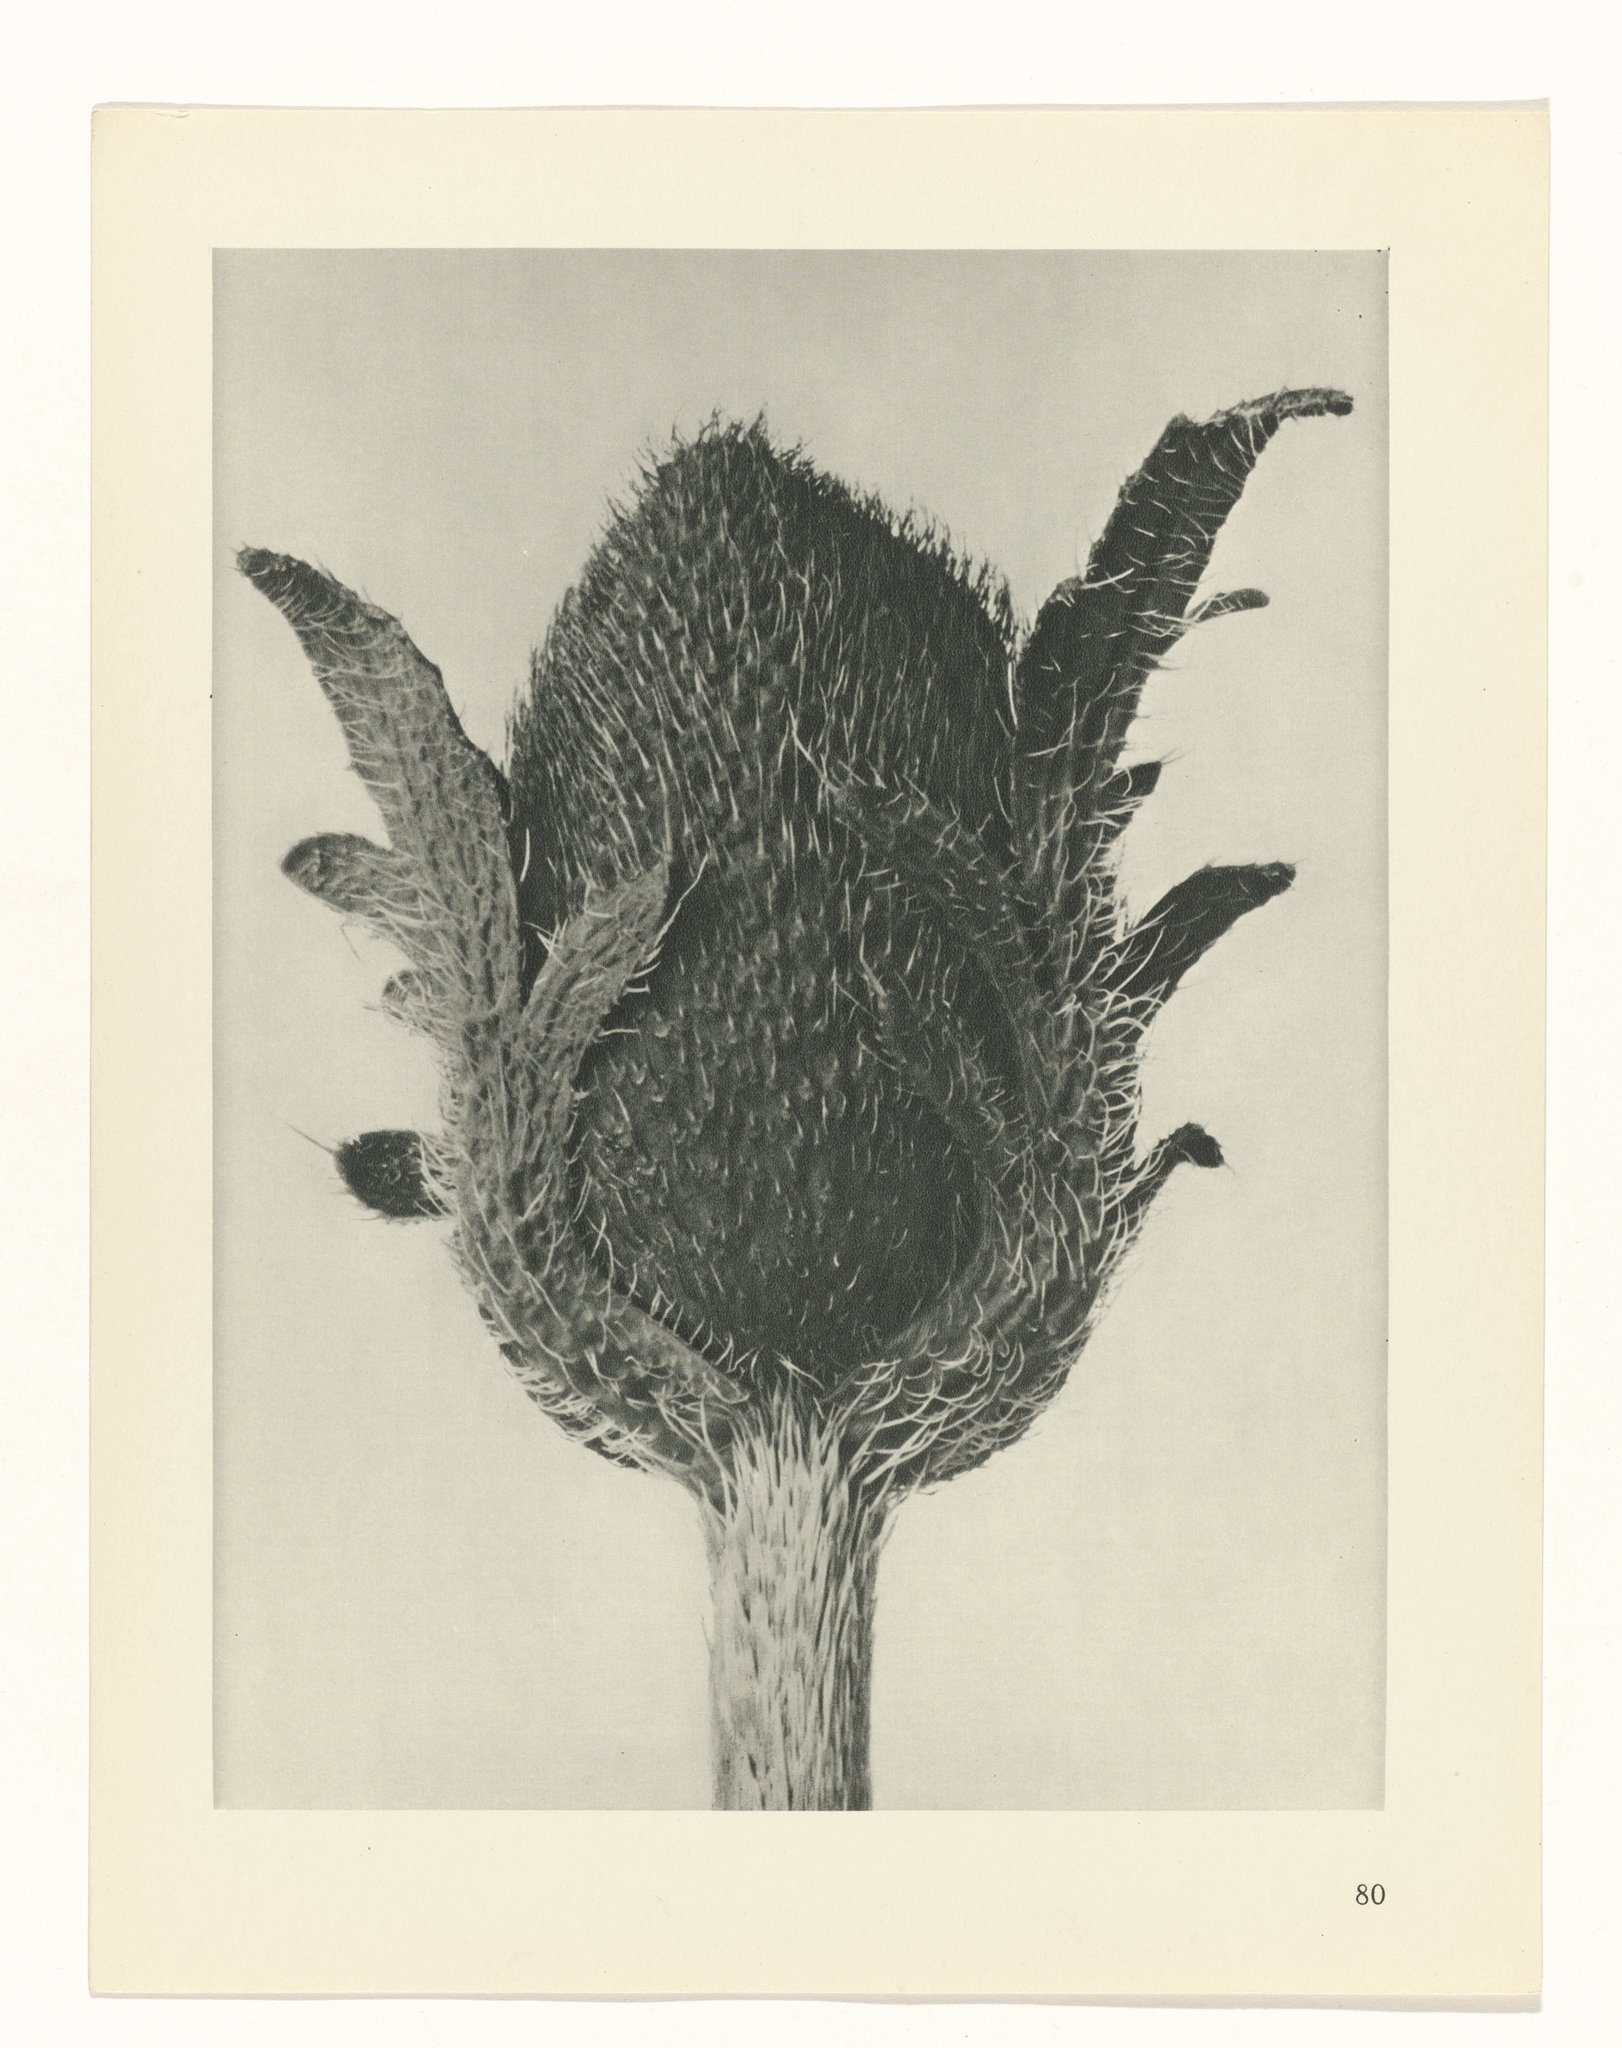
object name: photograph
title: Urformen der Kunst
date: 1928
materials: ink, paper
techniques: rotogravure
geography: berlin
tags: plants (in general)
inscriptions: number: ‘80’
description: facher Vergrößerung. Afkomstig uit losbladige uitgave.